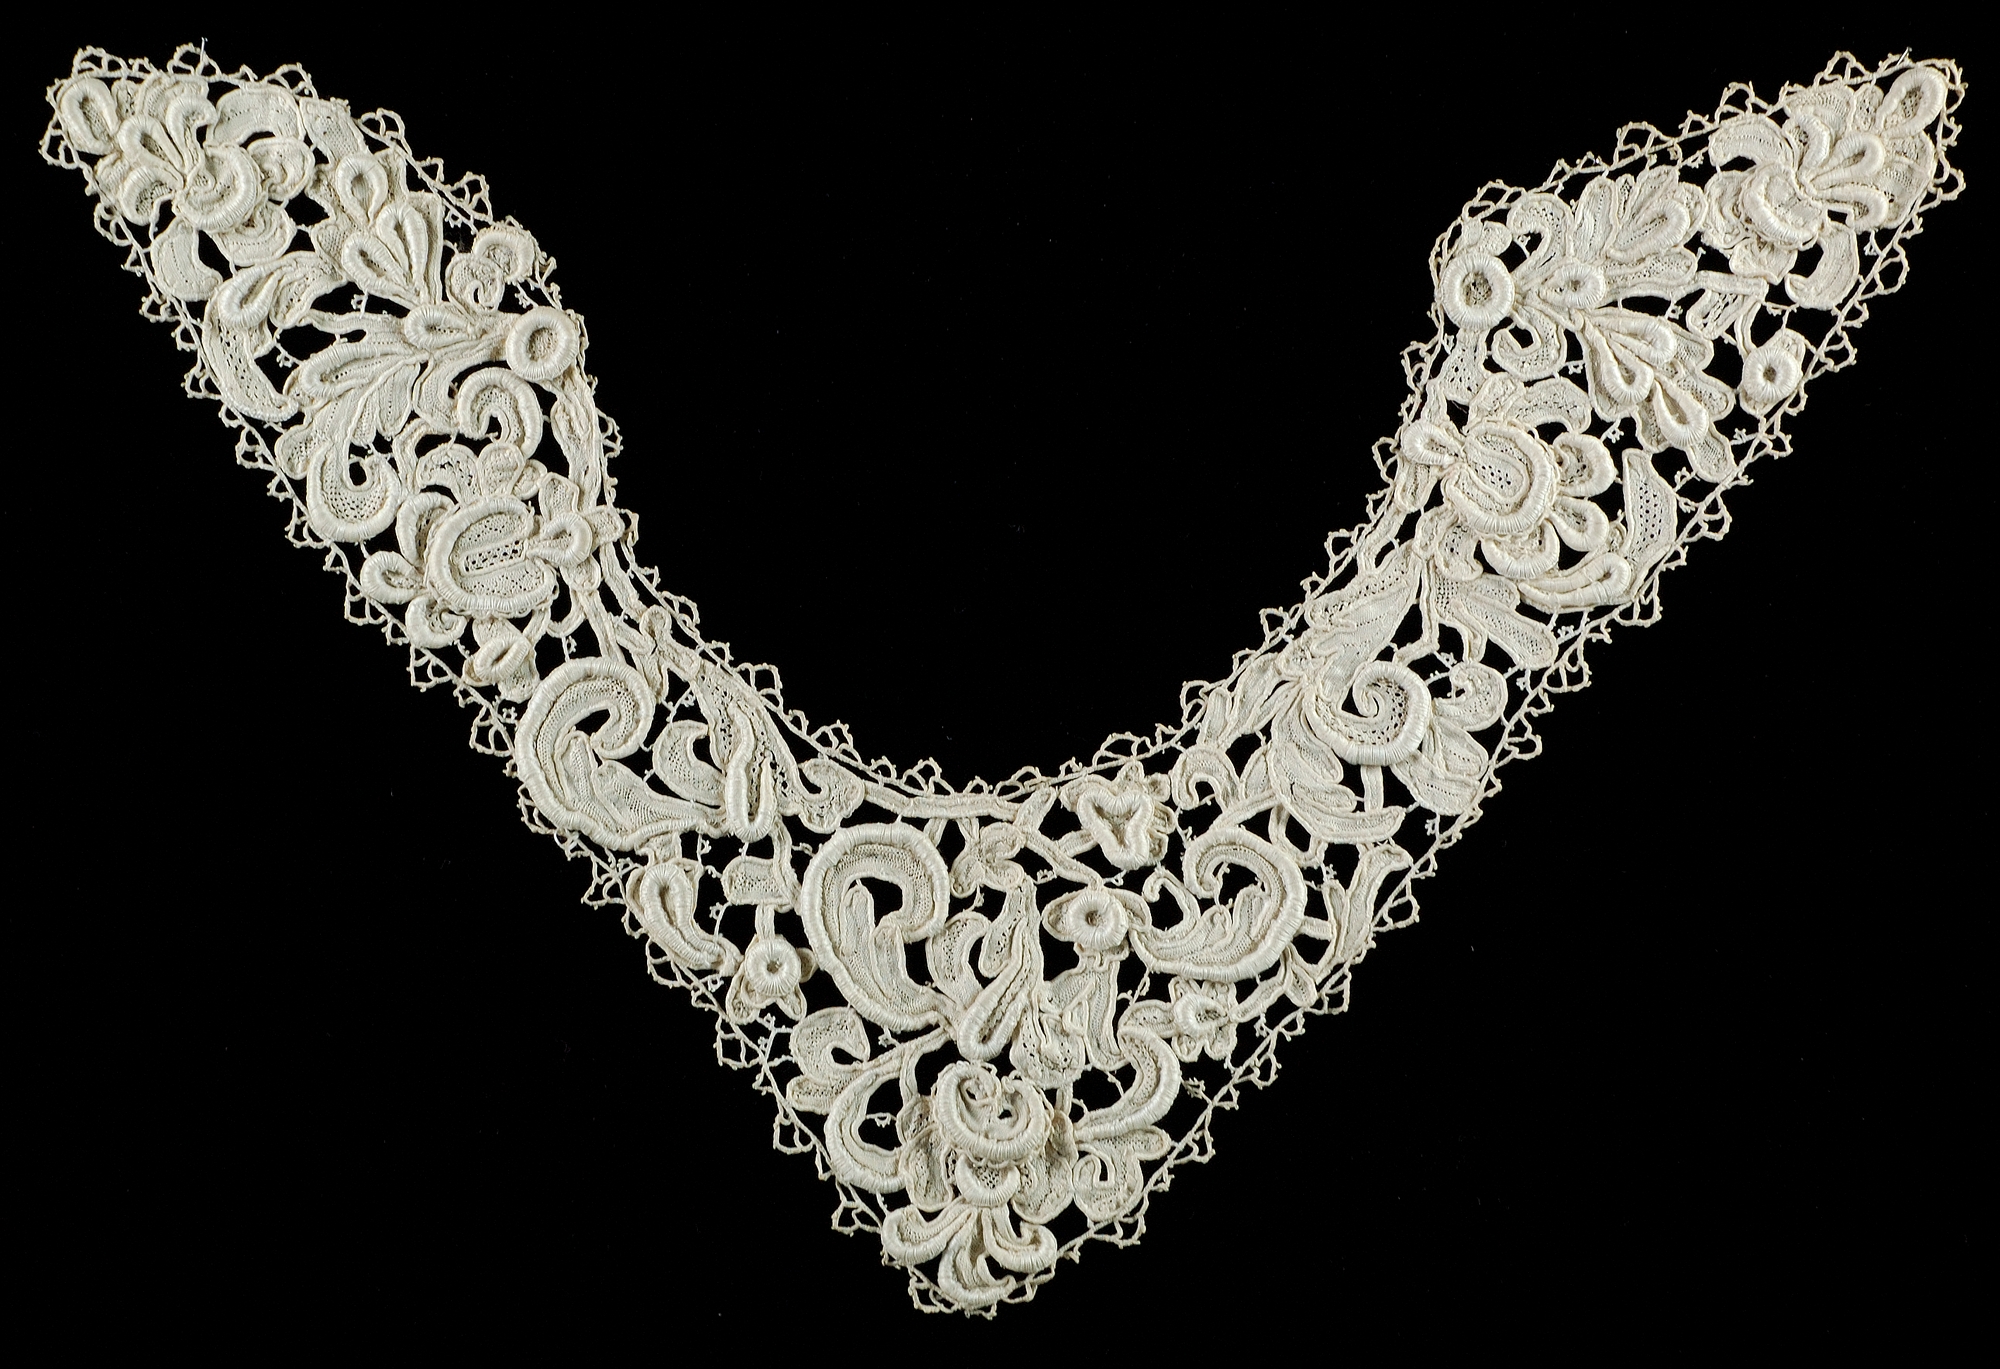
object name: collar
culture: italian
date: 1860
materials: linen